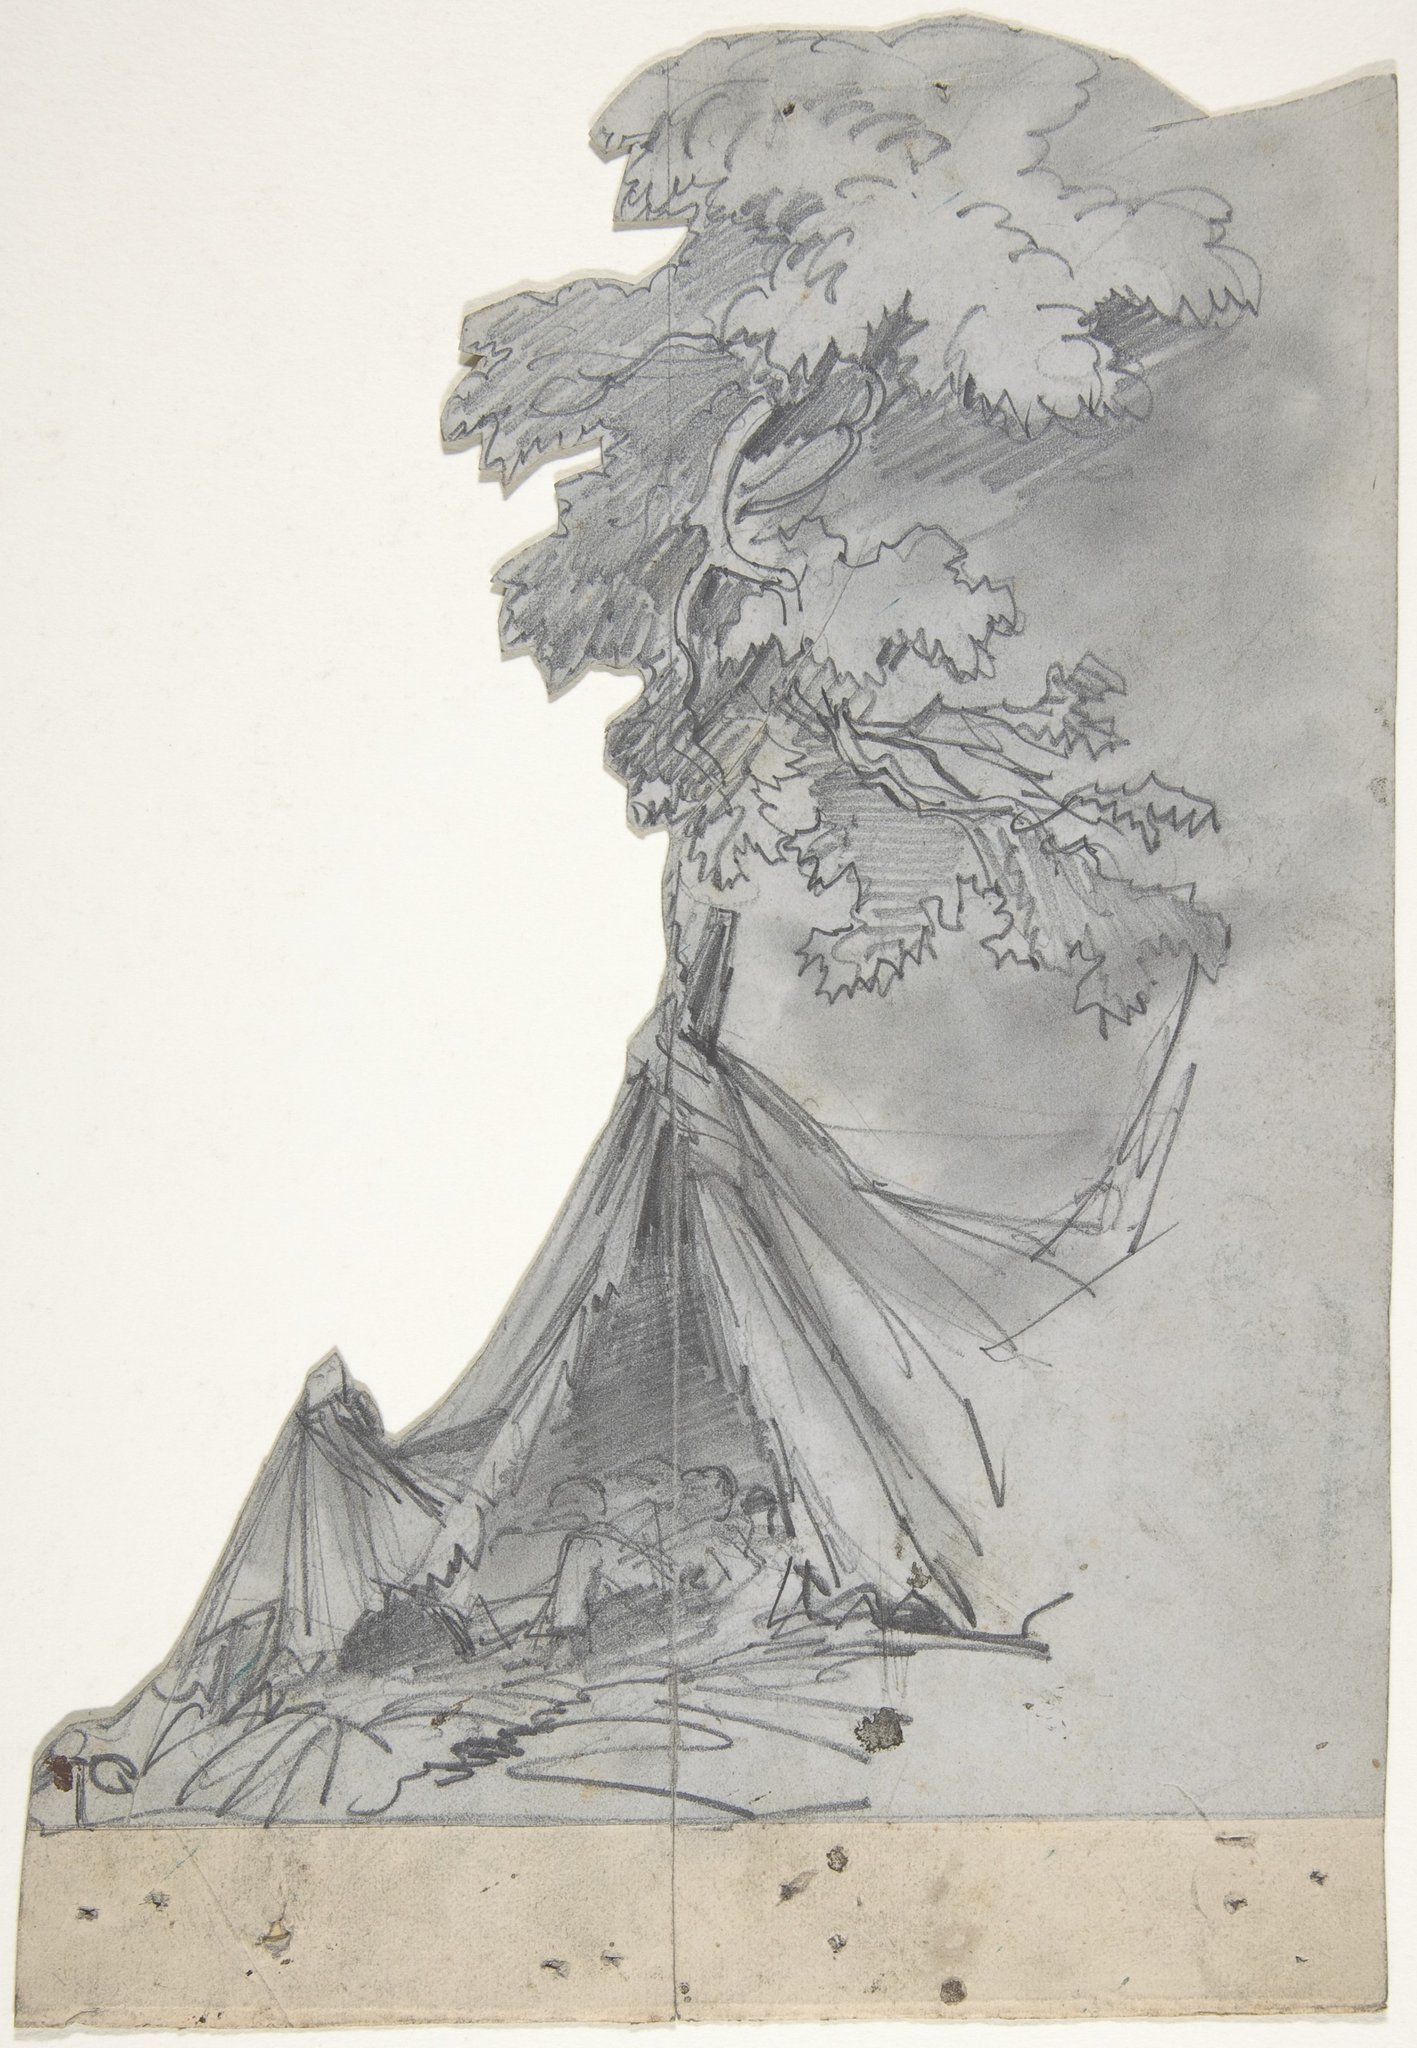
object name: drawing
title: Design for a Stage Set at the Opéra, Paris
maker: eugène cicéri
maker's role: artist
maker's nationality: french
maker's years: 1813-1890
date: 1830-1890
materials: graphite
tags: tents,stage design